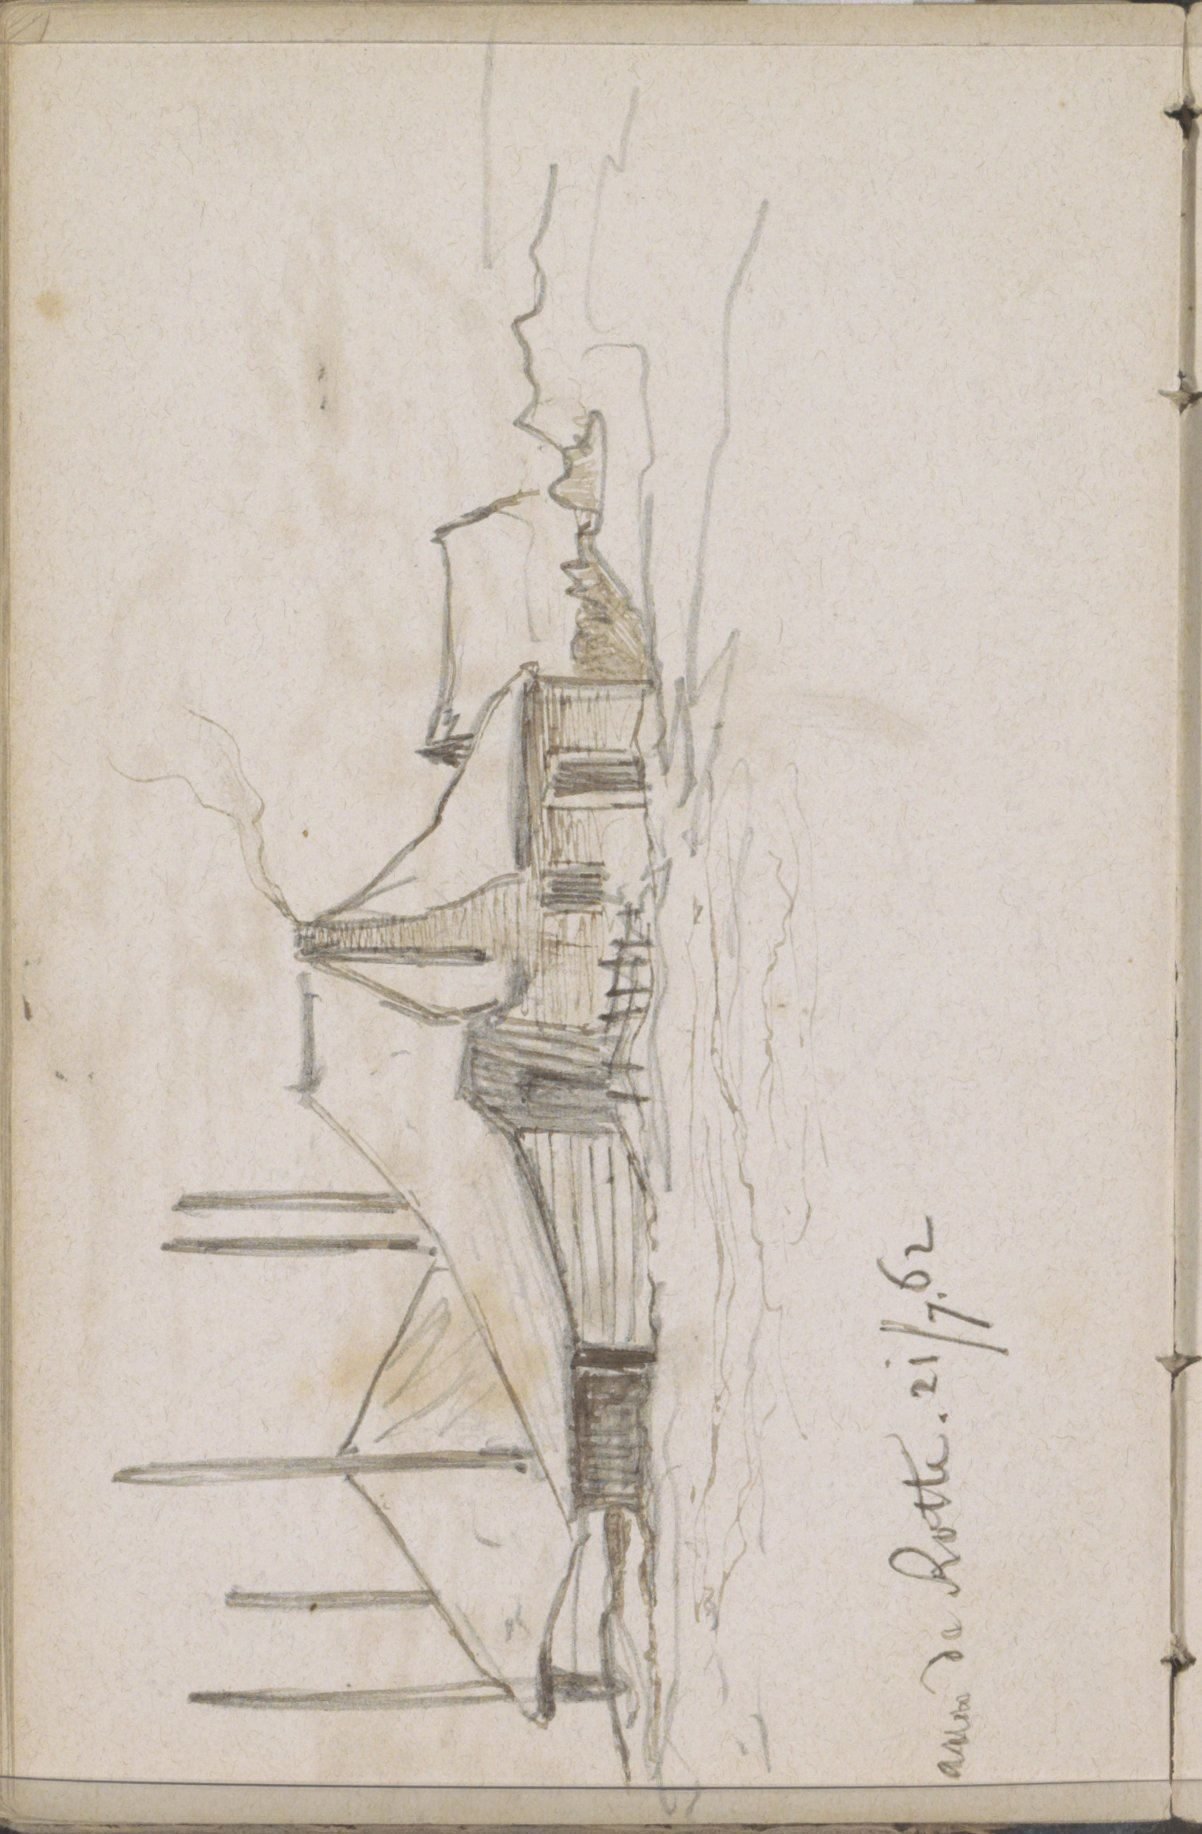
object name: sketchbook leaf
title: Boerenwoningen aan de Rotte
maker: johannes tavenraat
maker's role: draughtsman, painter, print maker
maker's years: 1809-1881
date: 1807-1862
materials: ink, paper, pencil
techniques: pen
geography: rotte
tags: rural housing, e.g. country-house, villa, cottage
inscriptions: date and inscription: ‘aan de Rotte. 21/7. 62’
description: Blad 24 verso uit een schetsboek met 65 bladen.